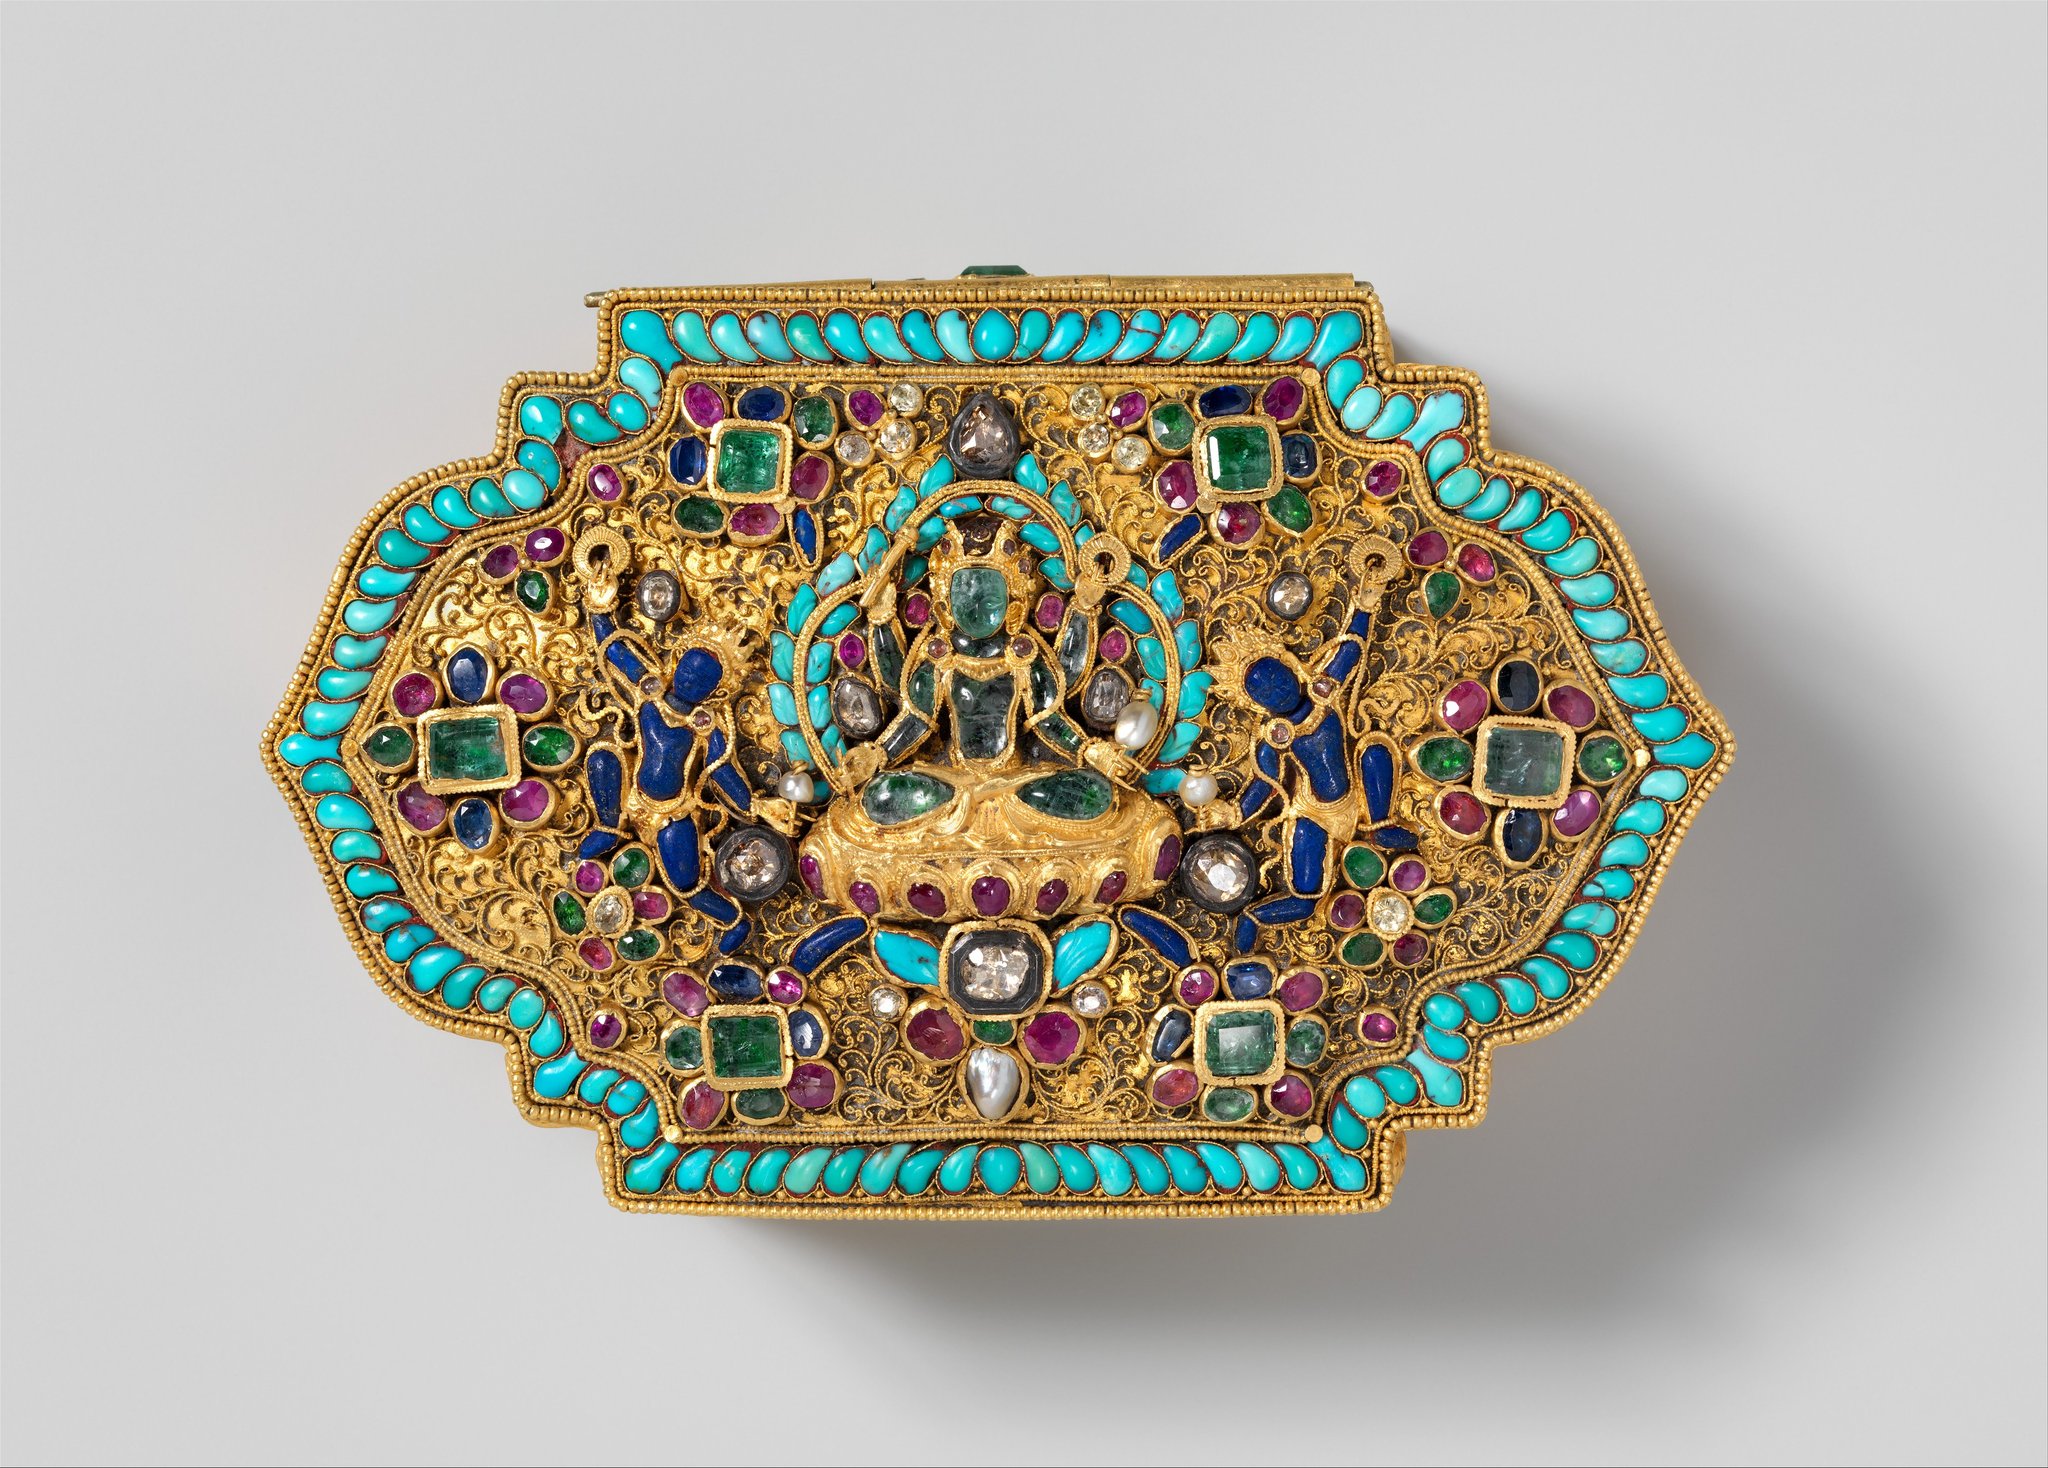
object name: box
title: Leaf-Shaped Box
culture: top decoration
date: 1601-1900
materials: gemstone, diamond, gold, lapis lazuli, pearl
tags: vishnu,hinduism